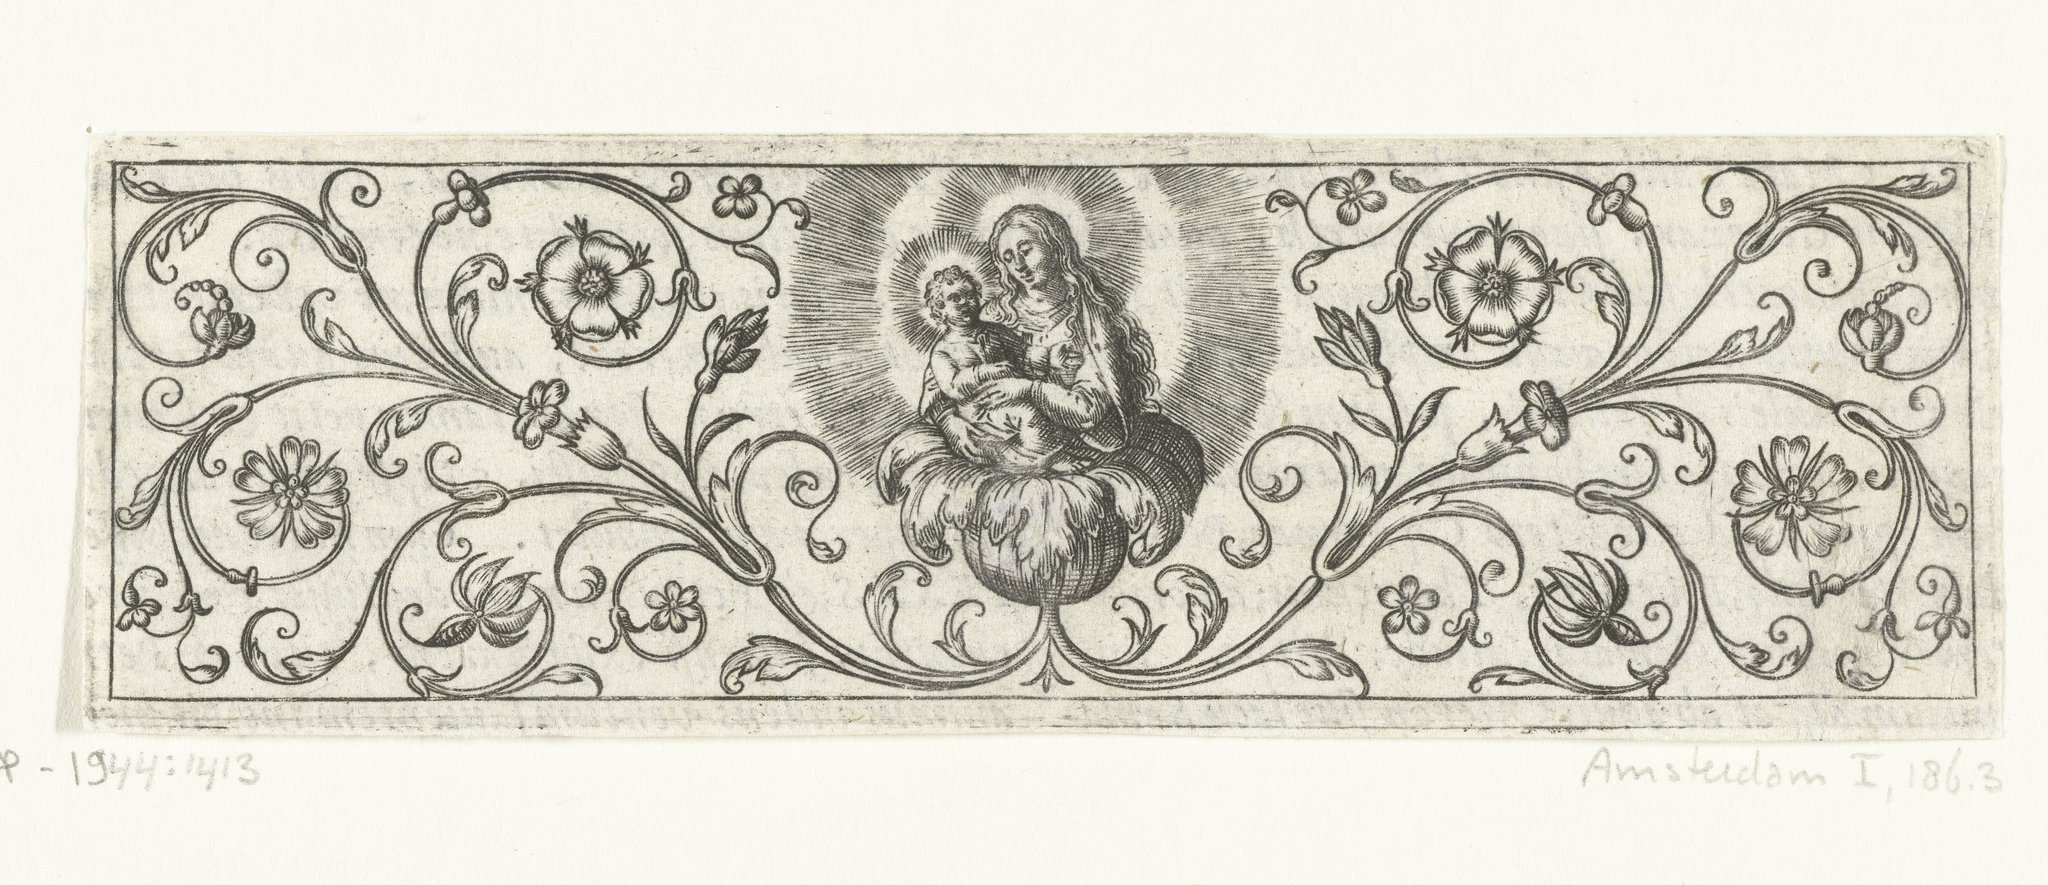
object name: ornament print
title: Adnotationes et meditationes…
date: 1594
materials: paper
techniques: engraving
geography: netherlands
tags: madonna: i.e. mary with the christ-child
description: Maria en kind rijzen op uit de kelk van een bloem. Afkomstig uit serie van 5 bladen uit het boek Adnotationes et meditationes… van P. Jeronimo Nadal.